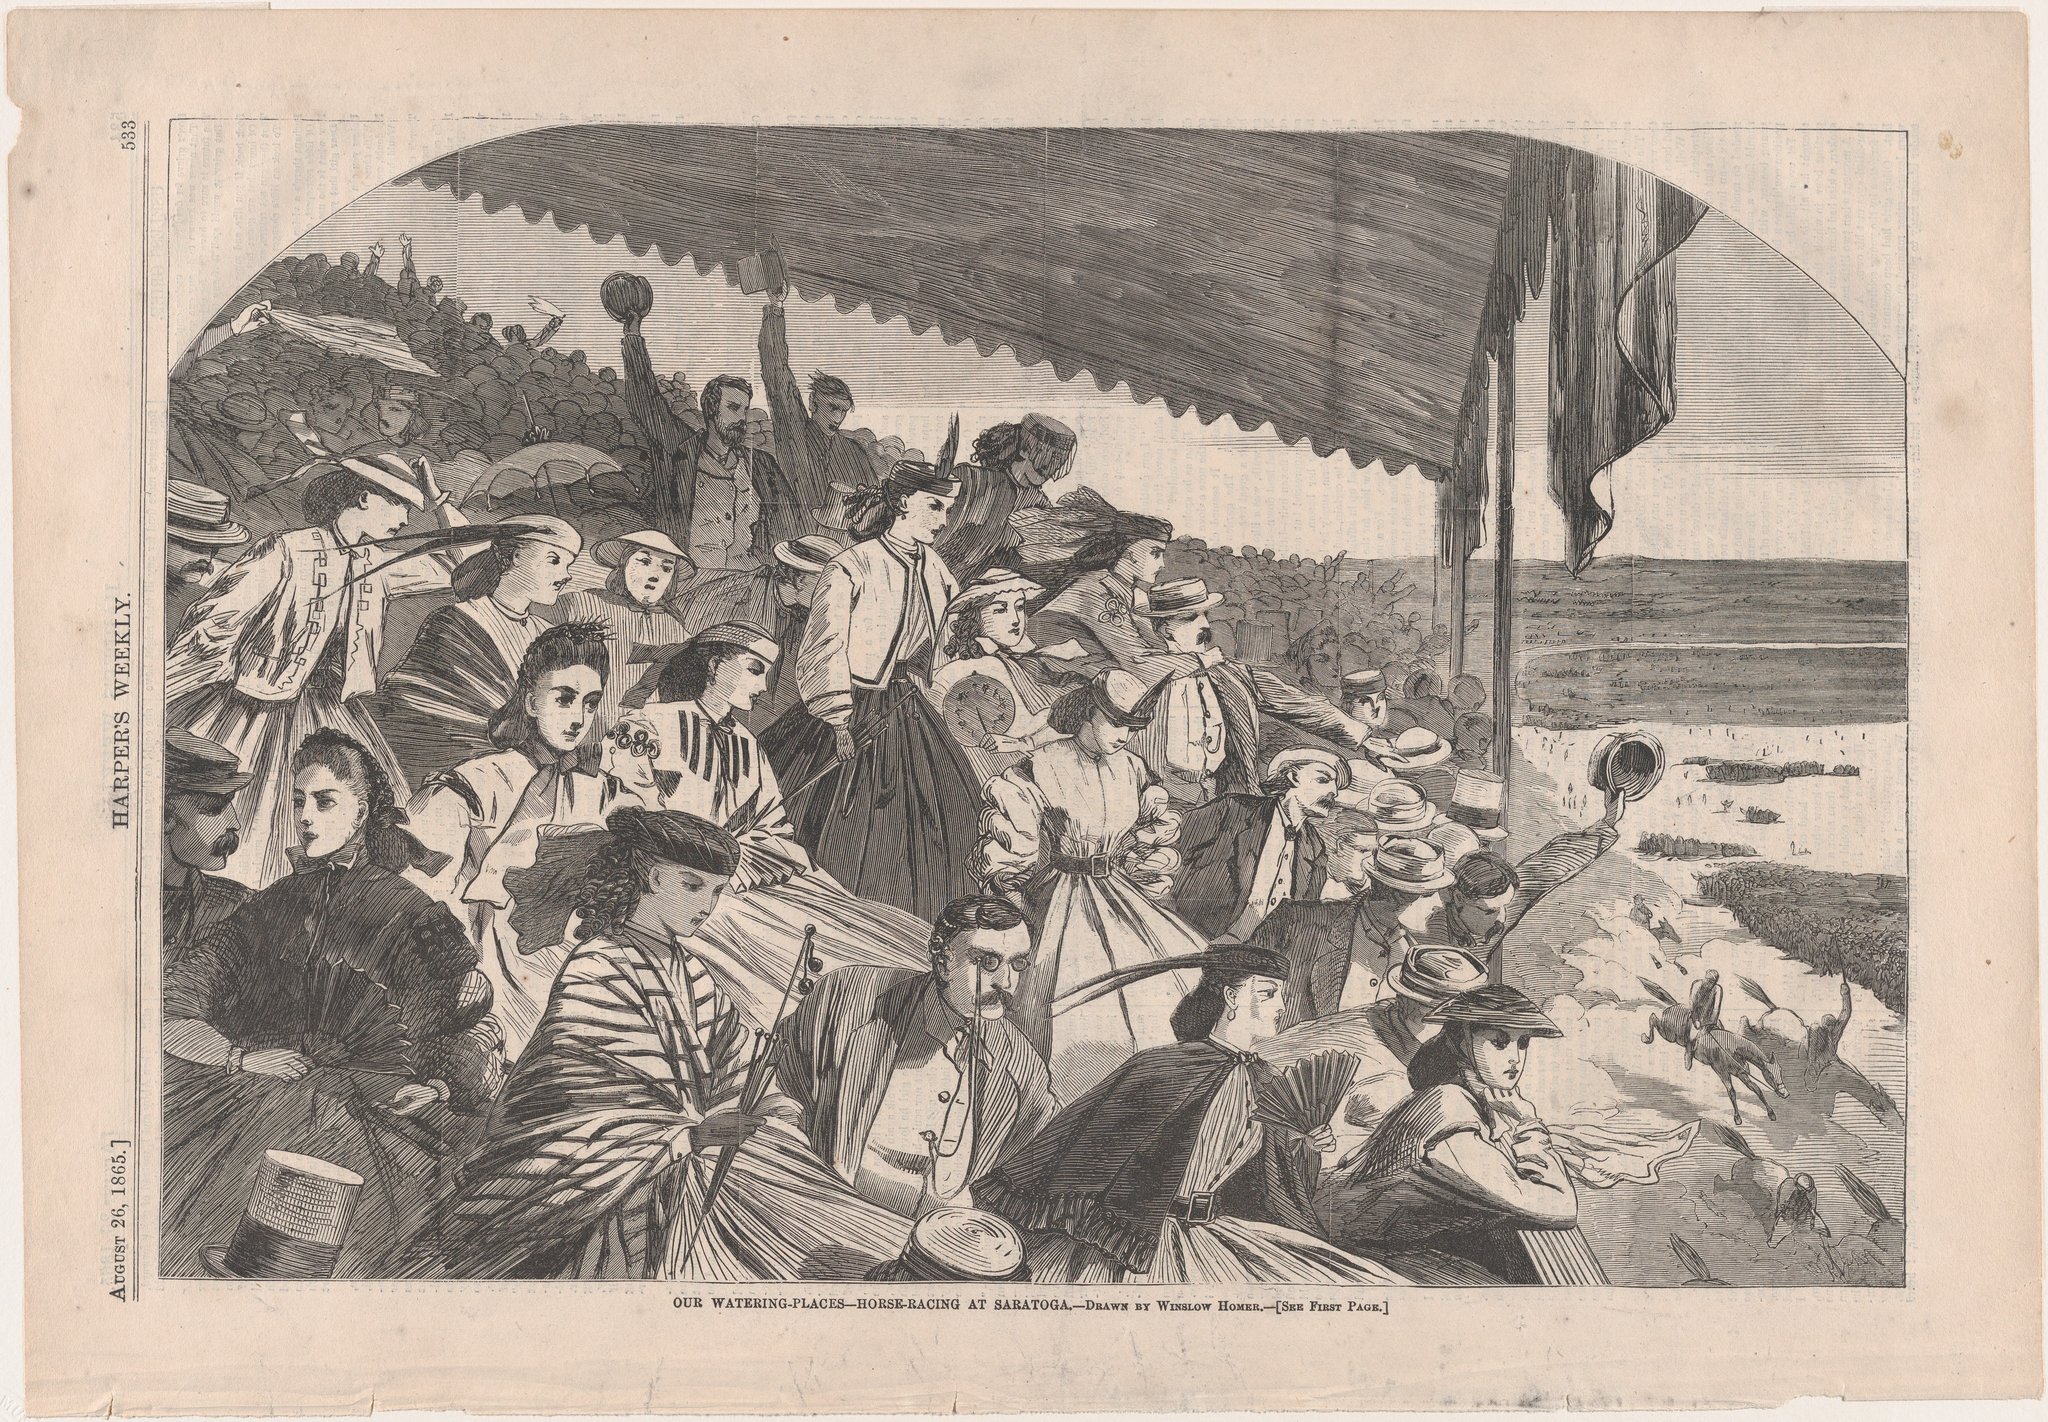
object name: print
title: Our Watering Places – Horse Racing at Saratoga (from "Harper's Weekly," Vol. IX)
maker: winslow homer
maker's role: artist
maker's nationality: american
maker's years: 1836-1910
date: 1865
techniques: engraving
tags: men,women,spectators,horses